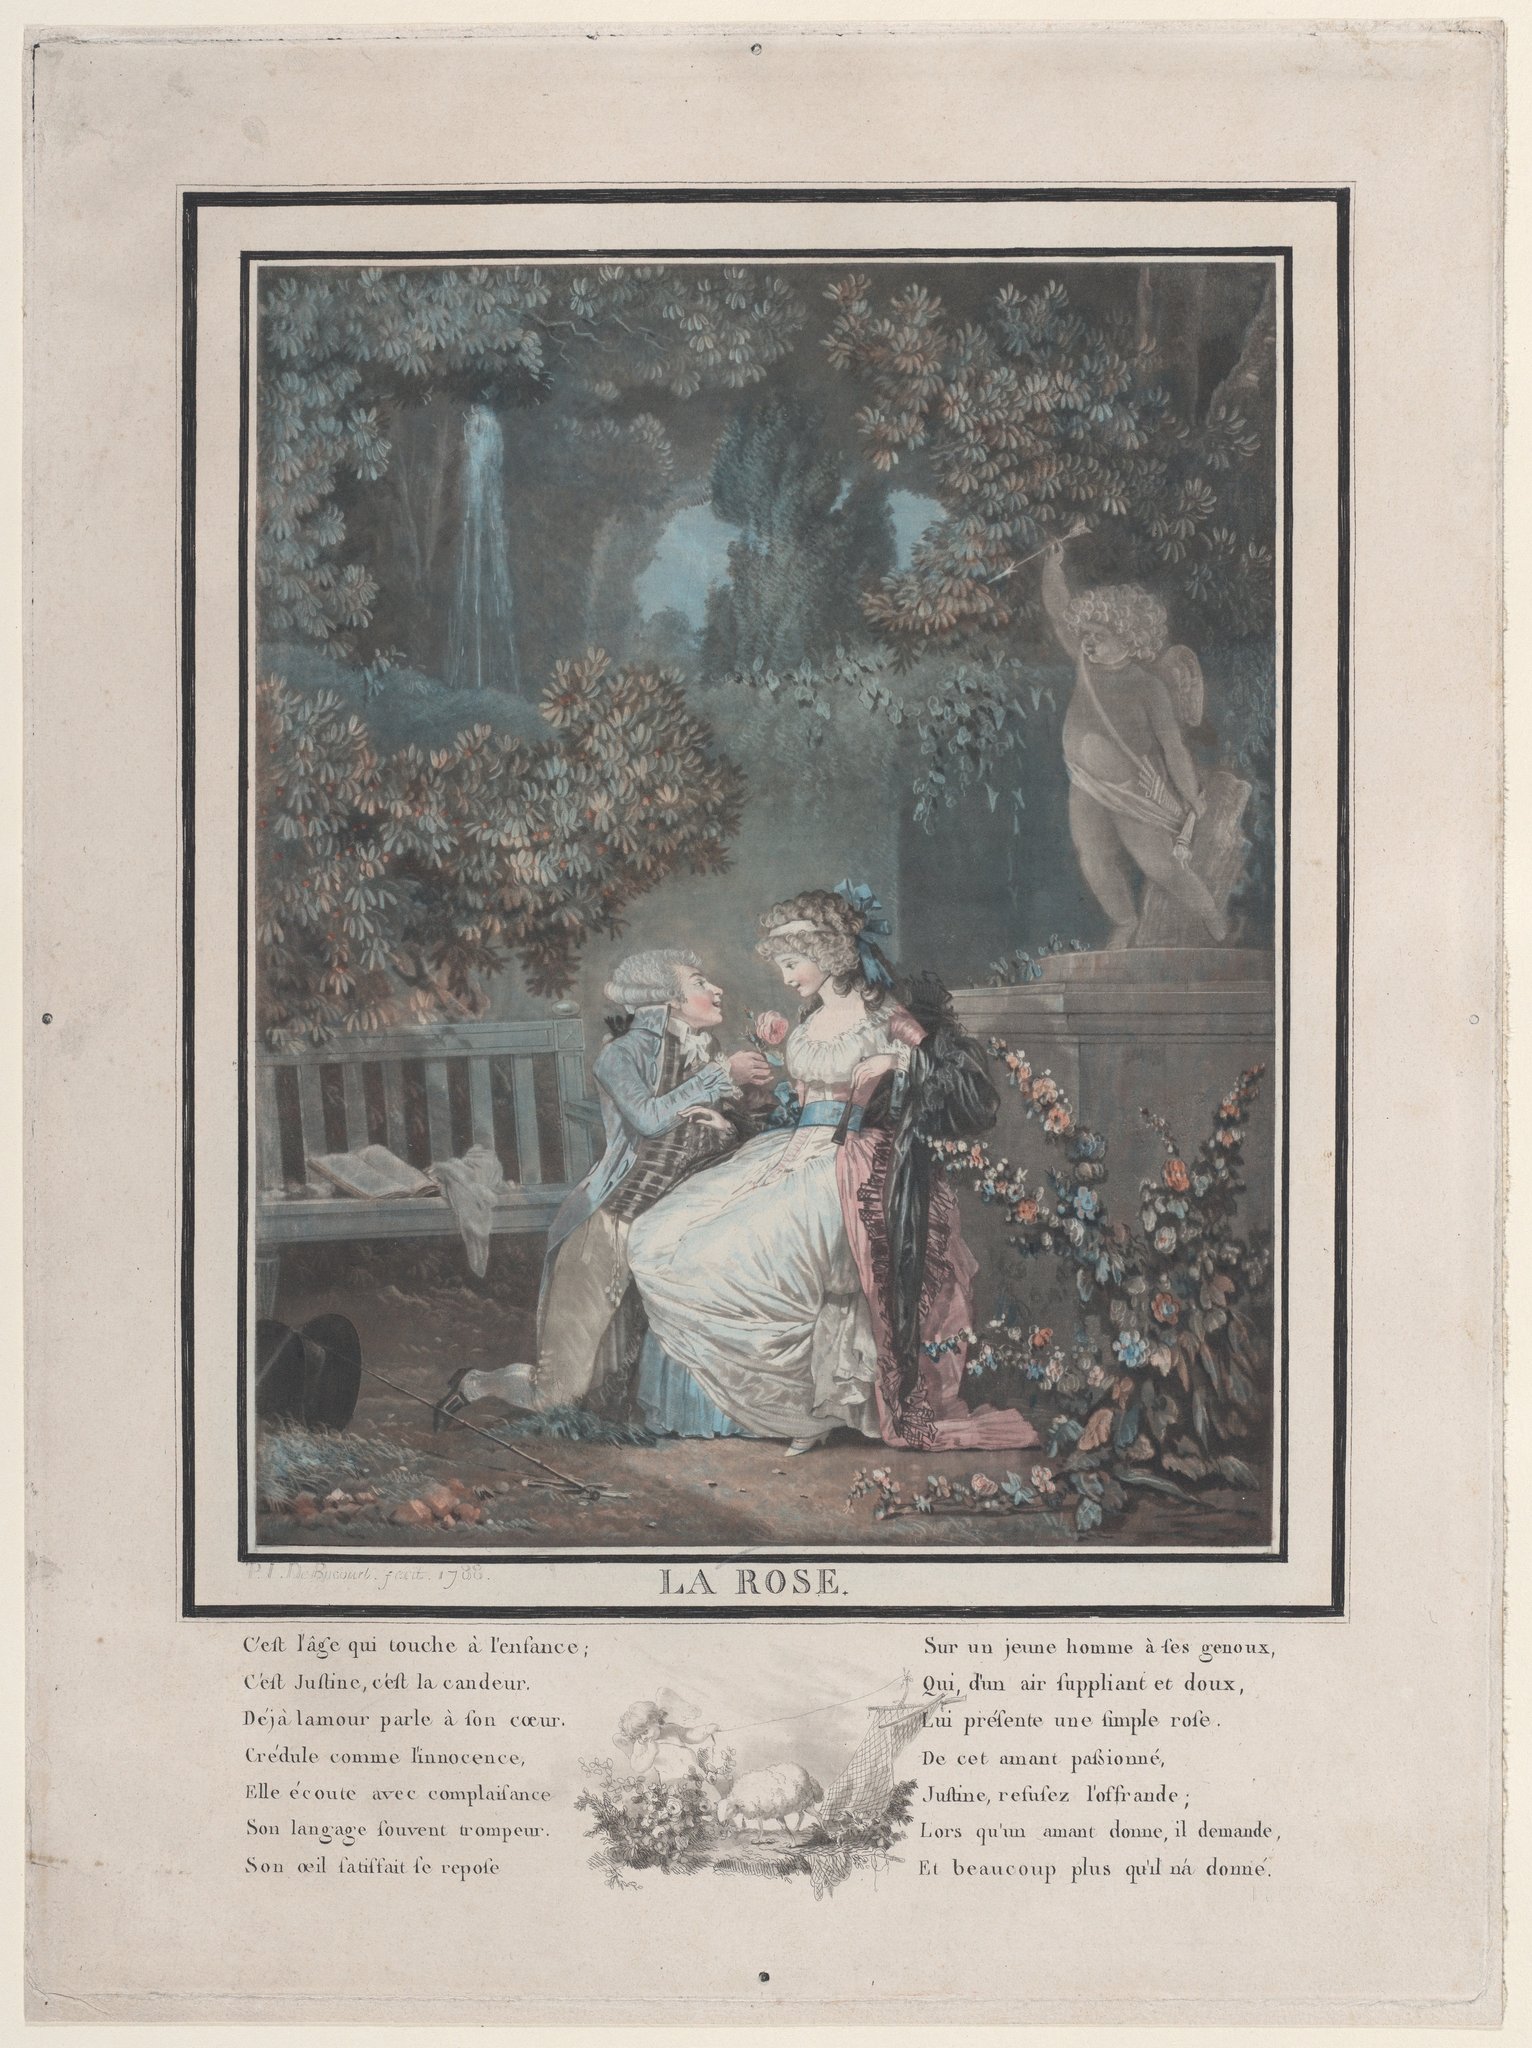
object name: print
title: The Rose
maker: louis philibert debucourt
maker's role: artist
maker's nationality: french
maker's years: 1755-1832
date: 1788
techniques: aquatint, etching, printing